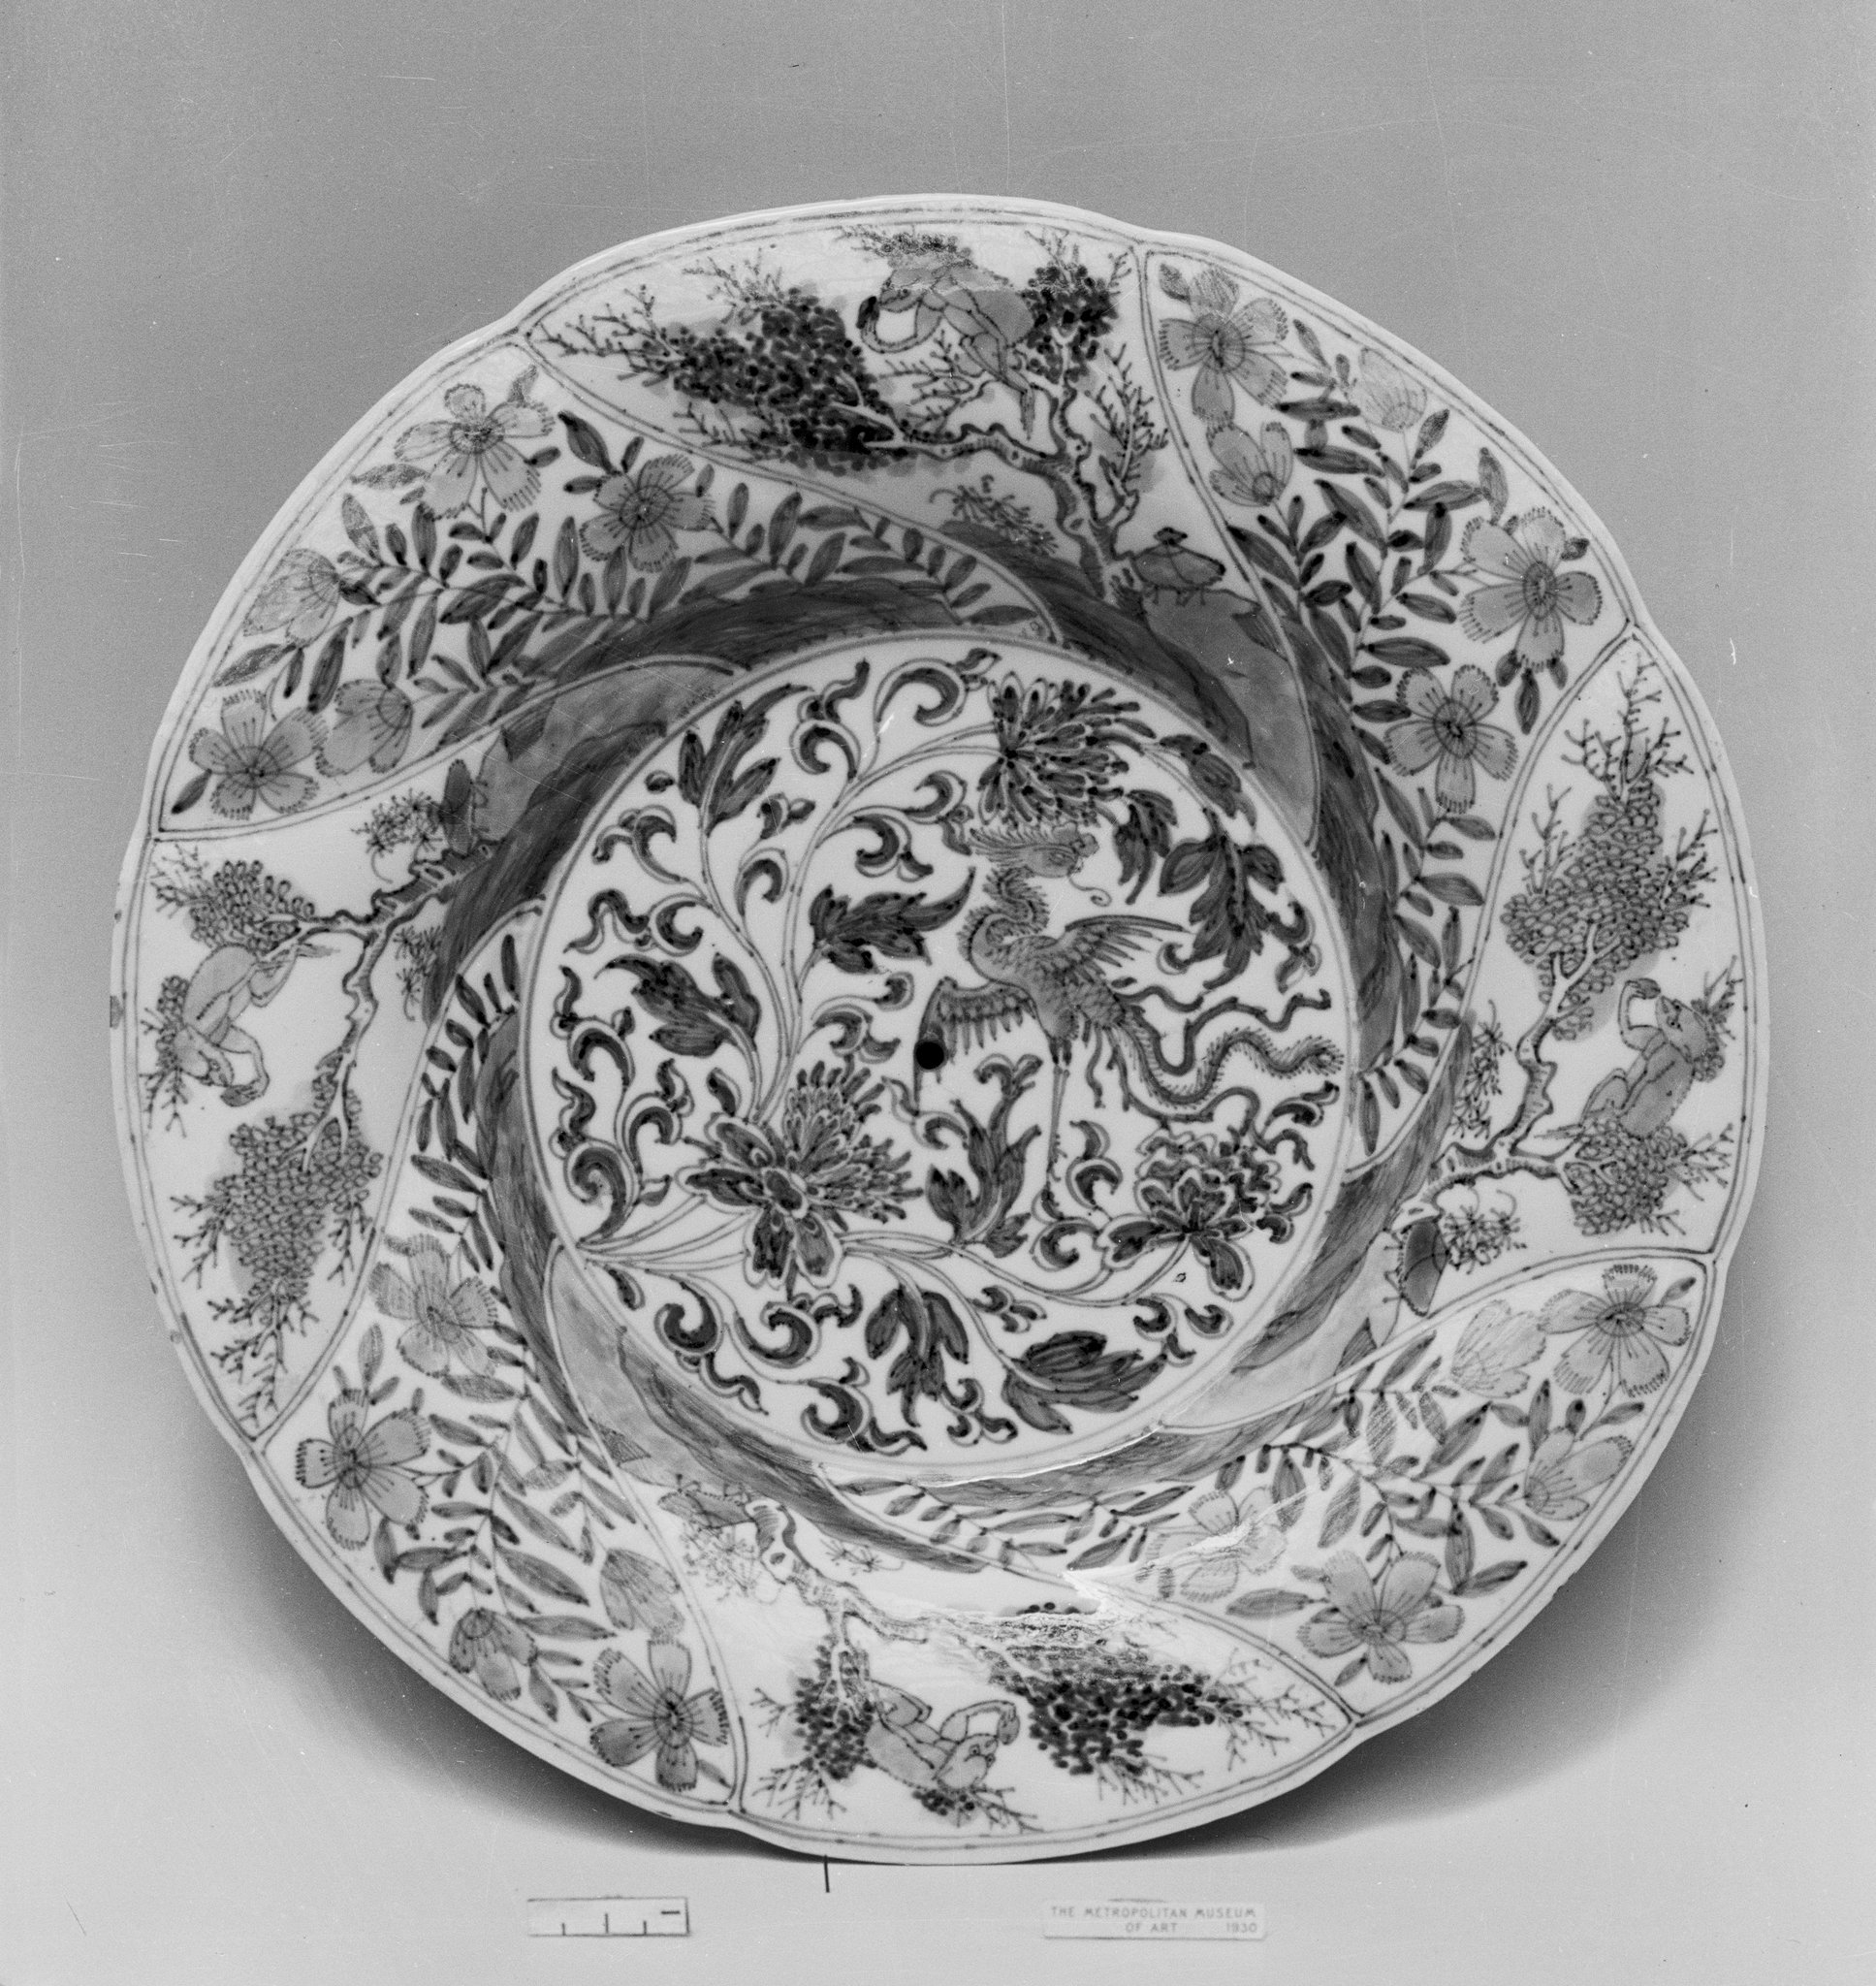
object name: plate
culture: chinese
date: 1662-1722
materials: porcelain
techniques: underglaze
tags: flowers